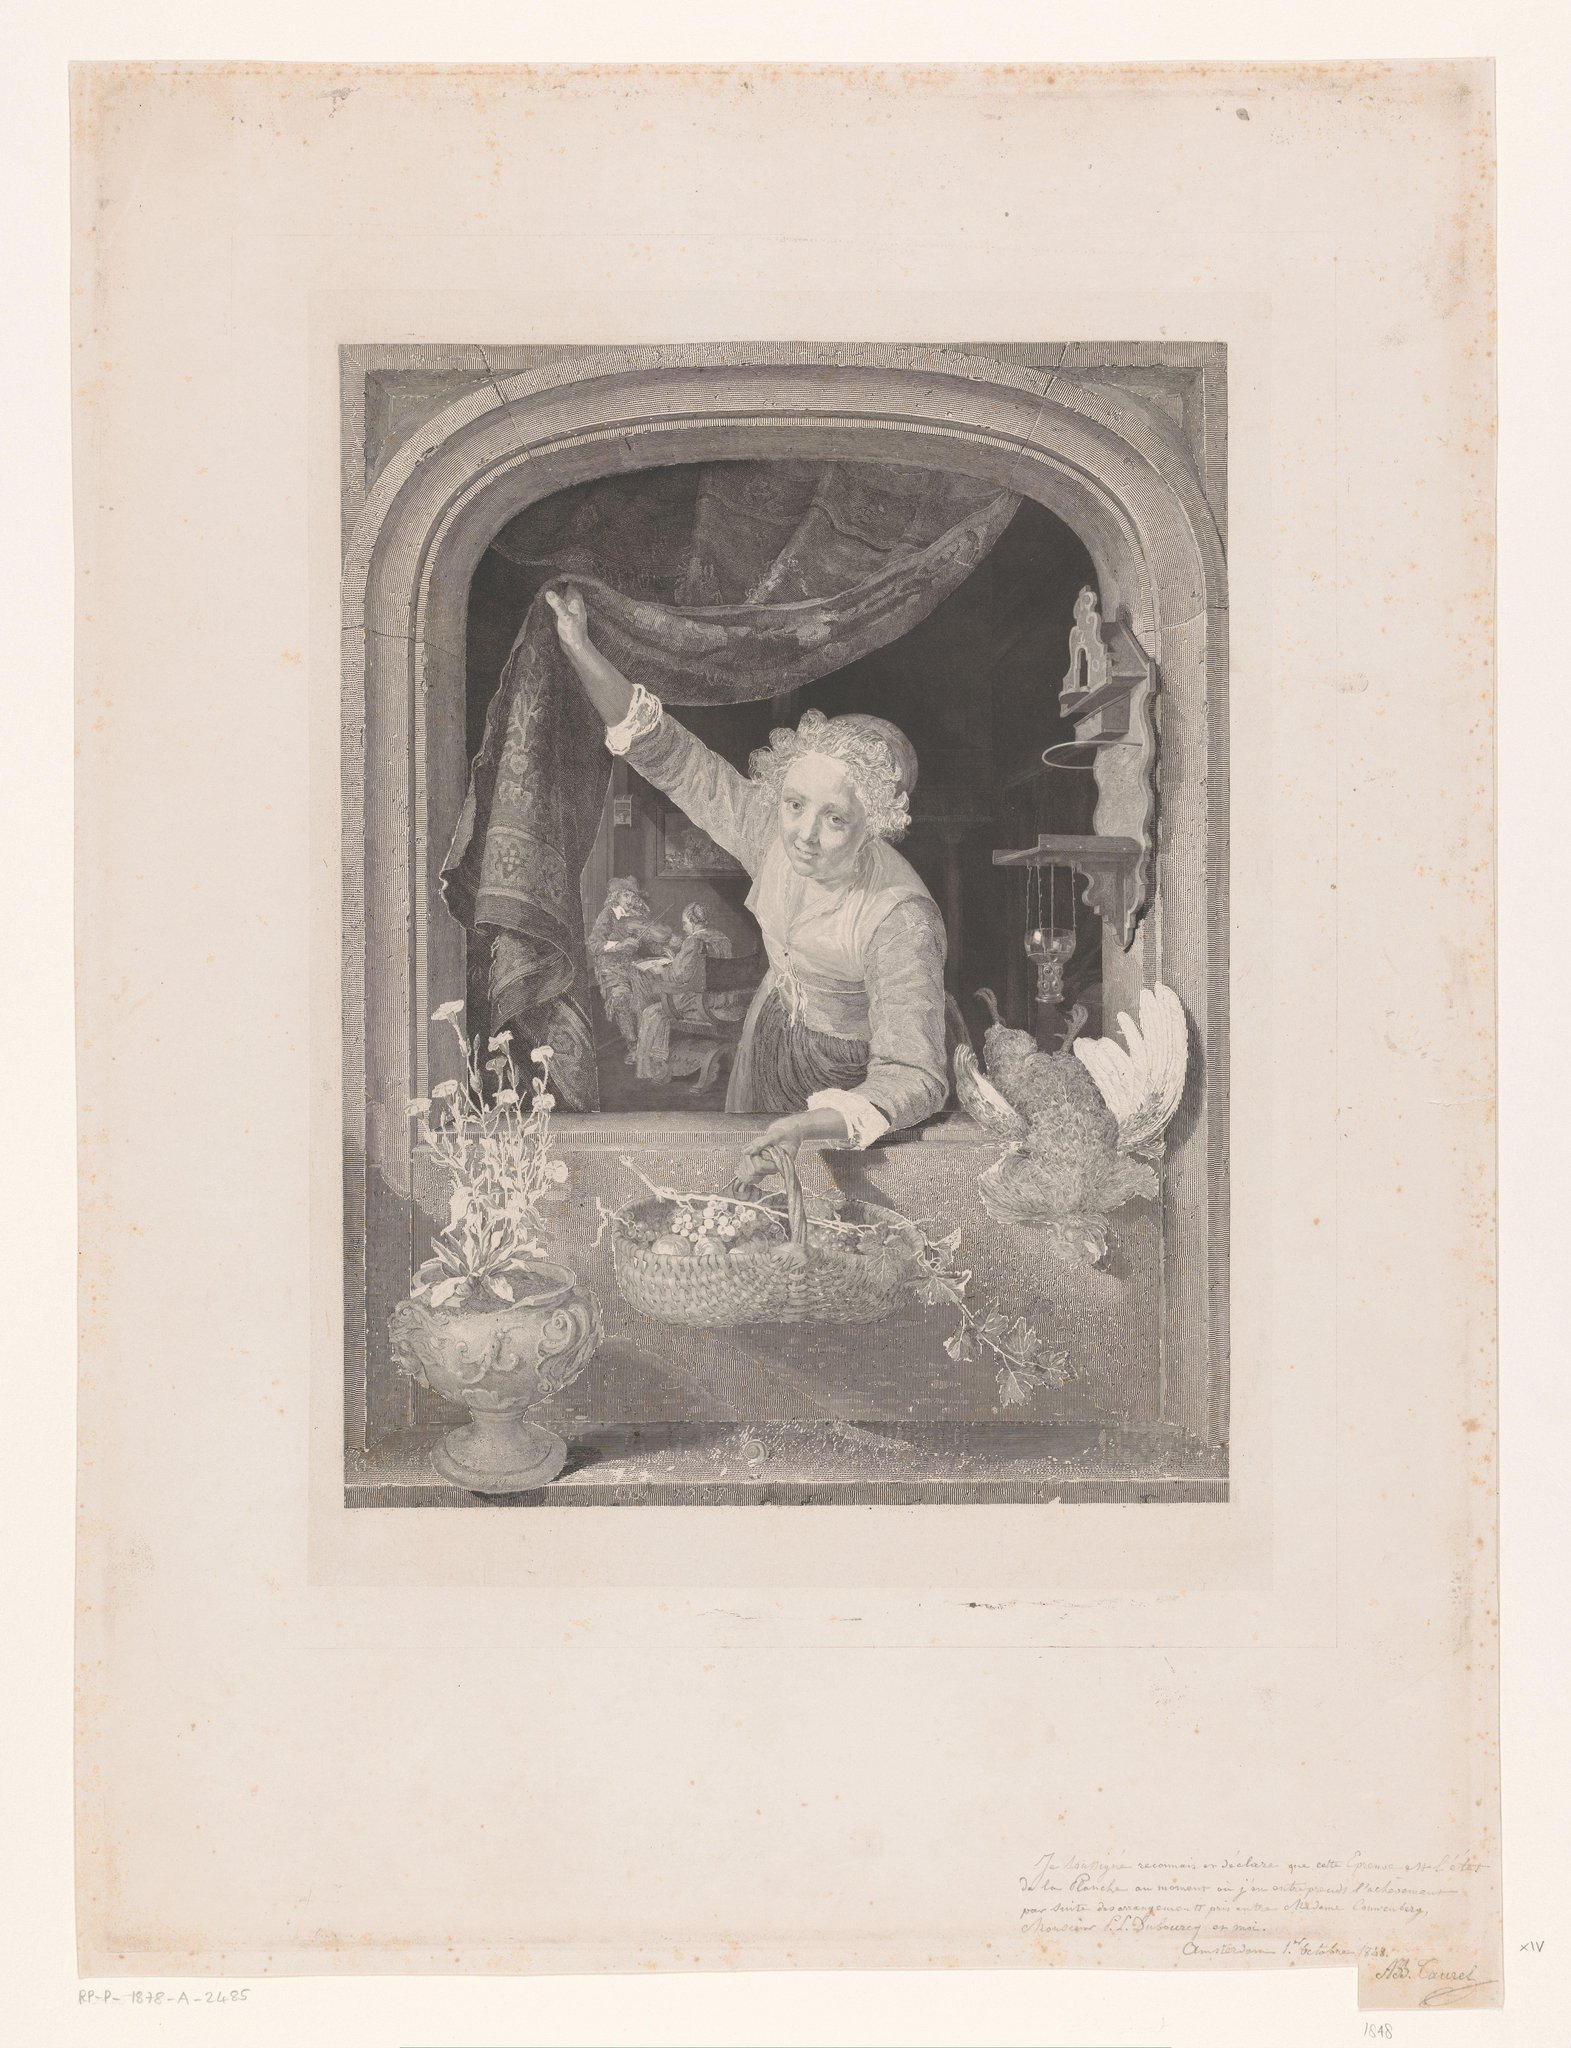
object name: print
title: Vrouw met mand met vruchten in de hand bij het raam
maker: henricus wilhelmus couwenberg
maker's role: draughtsman, print maker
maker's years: 1814-1845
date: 1848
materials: paper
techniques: etching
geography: amsterdam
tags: human figure at (open) window, seen from outside, shop-window, show-window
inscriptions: inscription: ‘Je souseigné reconais et déclare que cette Epreuve est l'Etat de la planche au moment ou j'en entreprends l'achévment par suite des arrangements pris entre Madame Couwenberg, Monsieur P.L. Dubourcq et moi. Amsterdam 1 er octobre 1848 A.B.B. Taurel’, collector's mark: Lugt 2228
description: Een jonge vrouw met een mand met vruchten in de hand hangt uit een venster. Ze houdt het gordijn opzij zodat het interieur achter haar zichtbaar is. In het vertrek zijn een man en een vrouw aan het musiceren. In de vensterbank hangt een vogelhuis, ligt een dode haan en staat een vaas met bloemen.